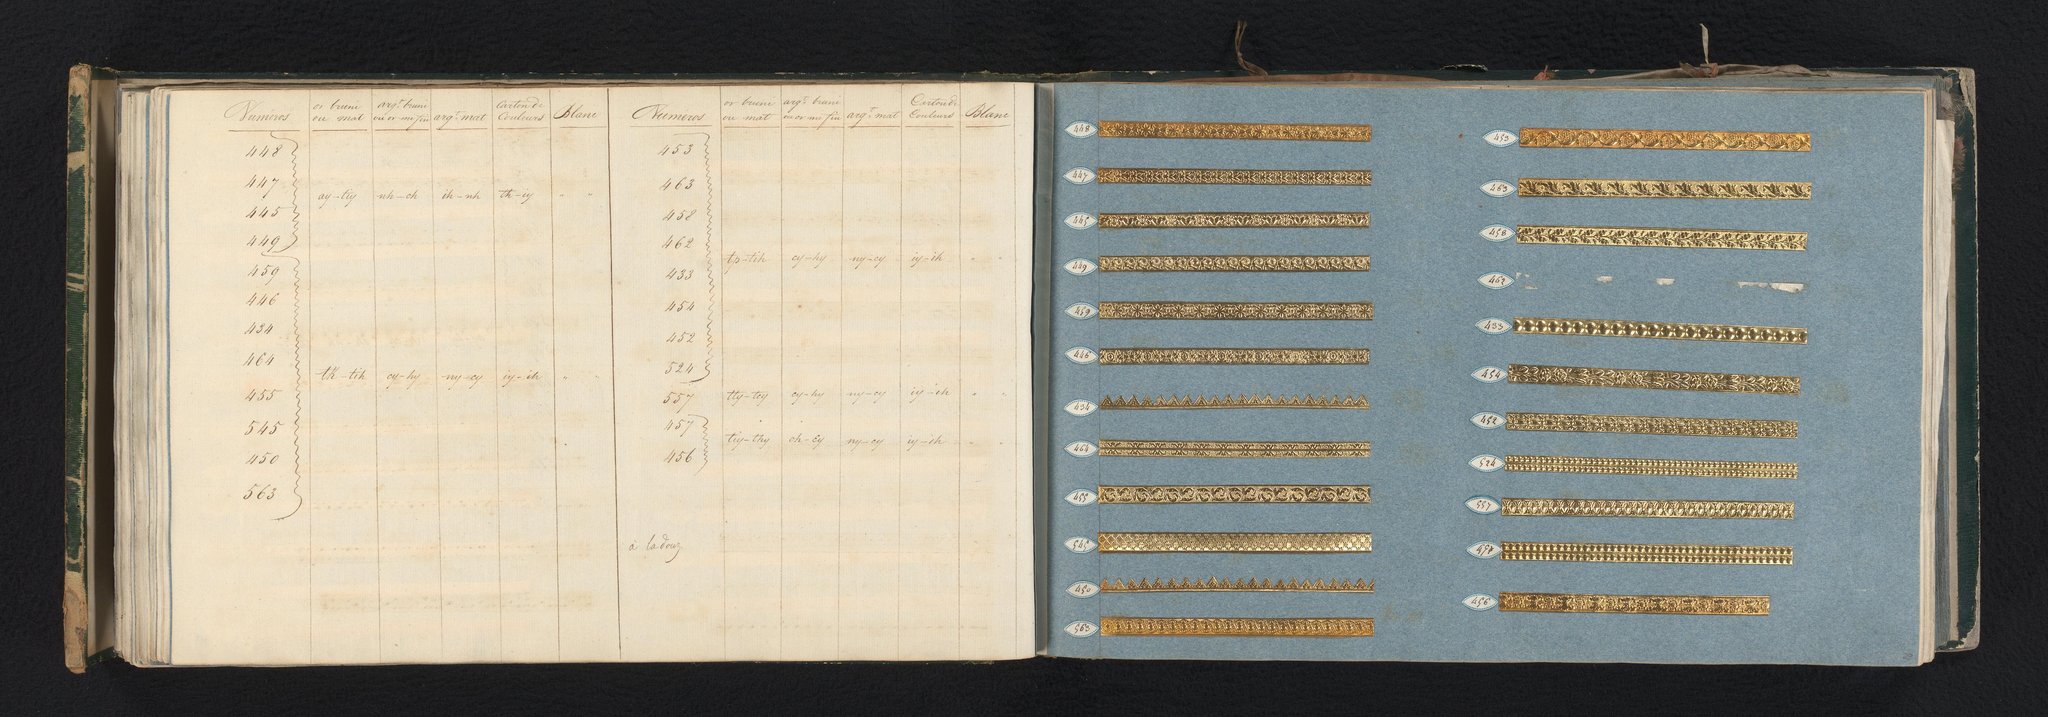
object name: album leaf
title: Twee bladzijden met stalen van sierlijsten van goudkleurig metaalpapier en bijbehorend tabel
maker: Anonymous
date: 1830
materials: gold leaf, ink, paper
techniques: manufacturing, writing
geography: france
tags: ornaments ~ art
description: Twee bladzijden met rechts 22 opgeplakte en met etiketten genummerde (448-456) stalen van smalle, eenvoudig gedecoreerde sierlijsten van goudkleurig metaalpapier (staal nr. 462 ontbreekt). Op de tegenoverliggende linkerbladzijde een tabel met de handgeschreven corresponderende specificaties (in code) per ornament. Onderdeel van het stalenboek geschonken door de dames Van Rijn, vermoedelijk van een Franse papierfabrikant van luxe papieren, of diens vertegenwoordiger in Nederland, ca. 1830.